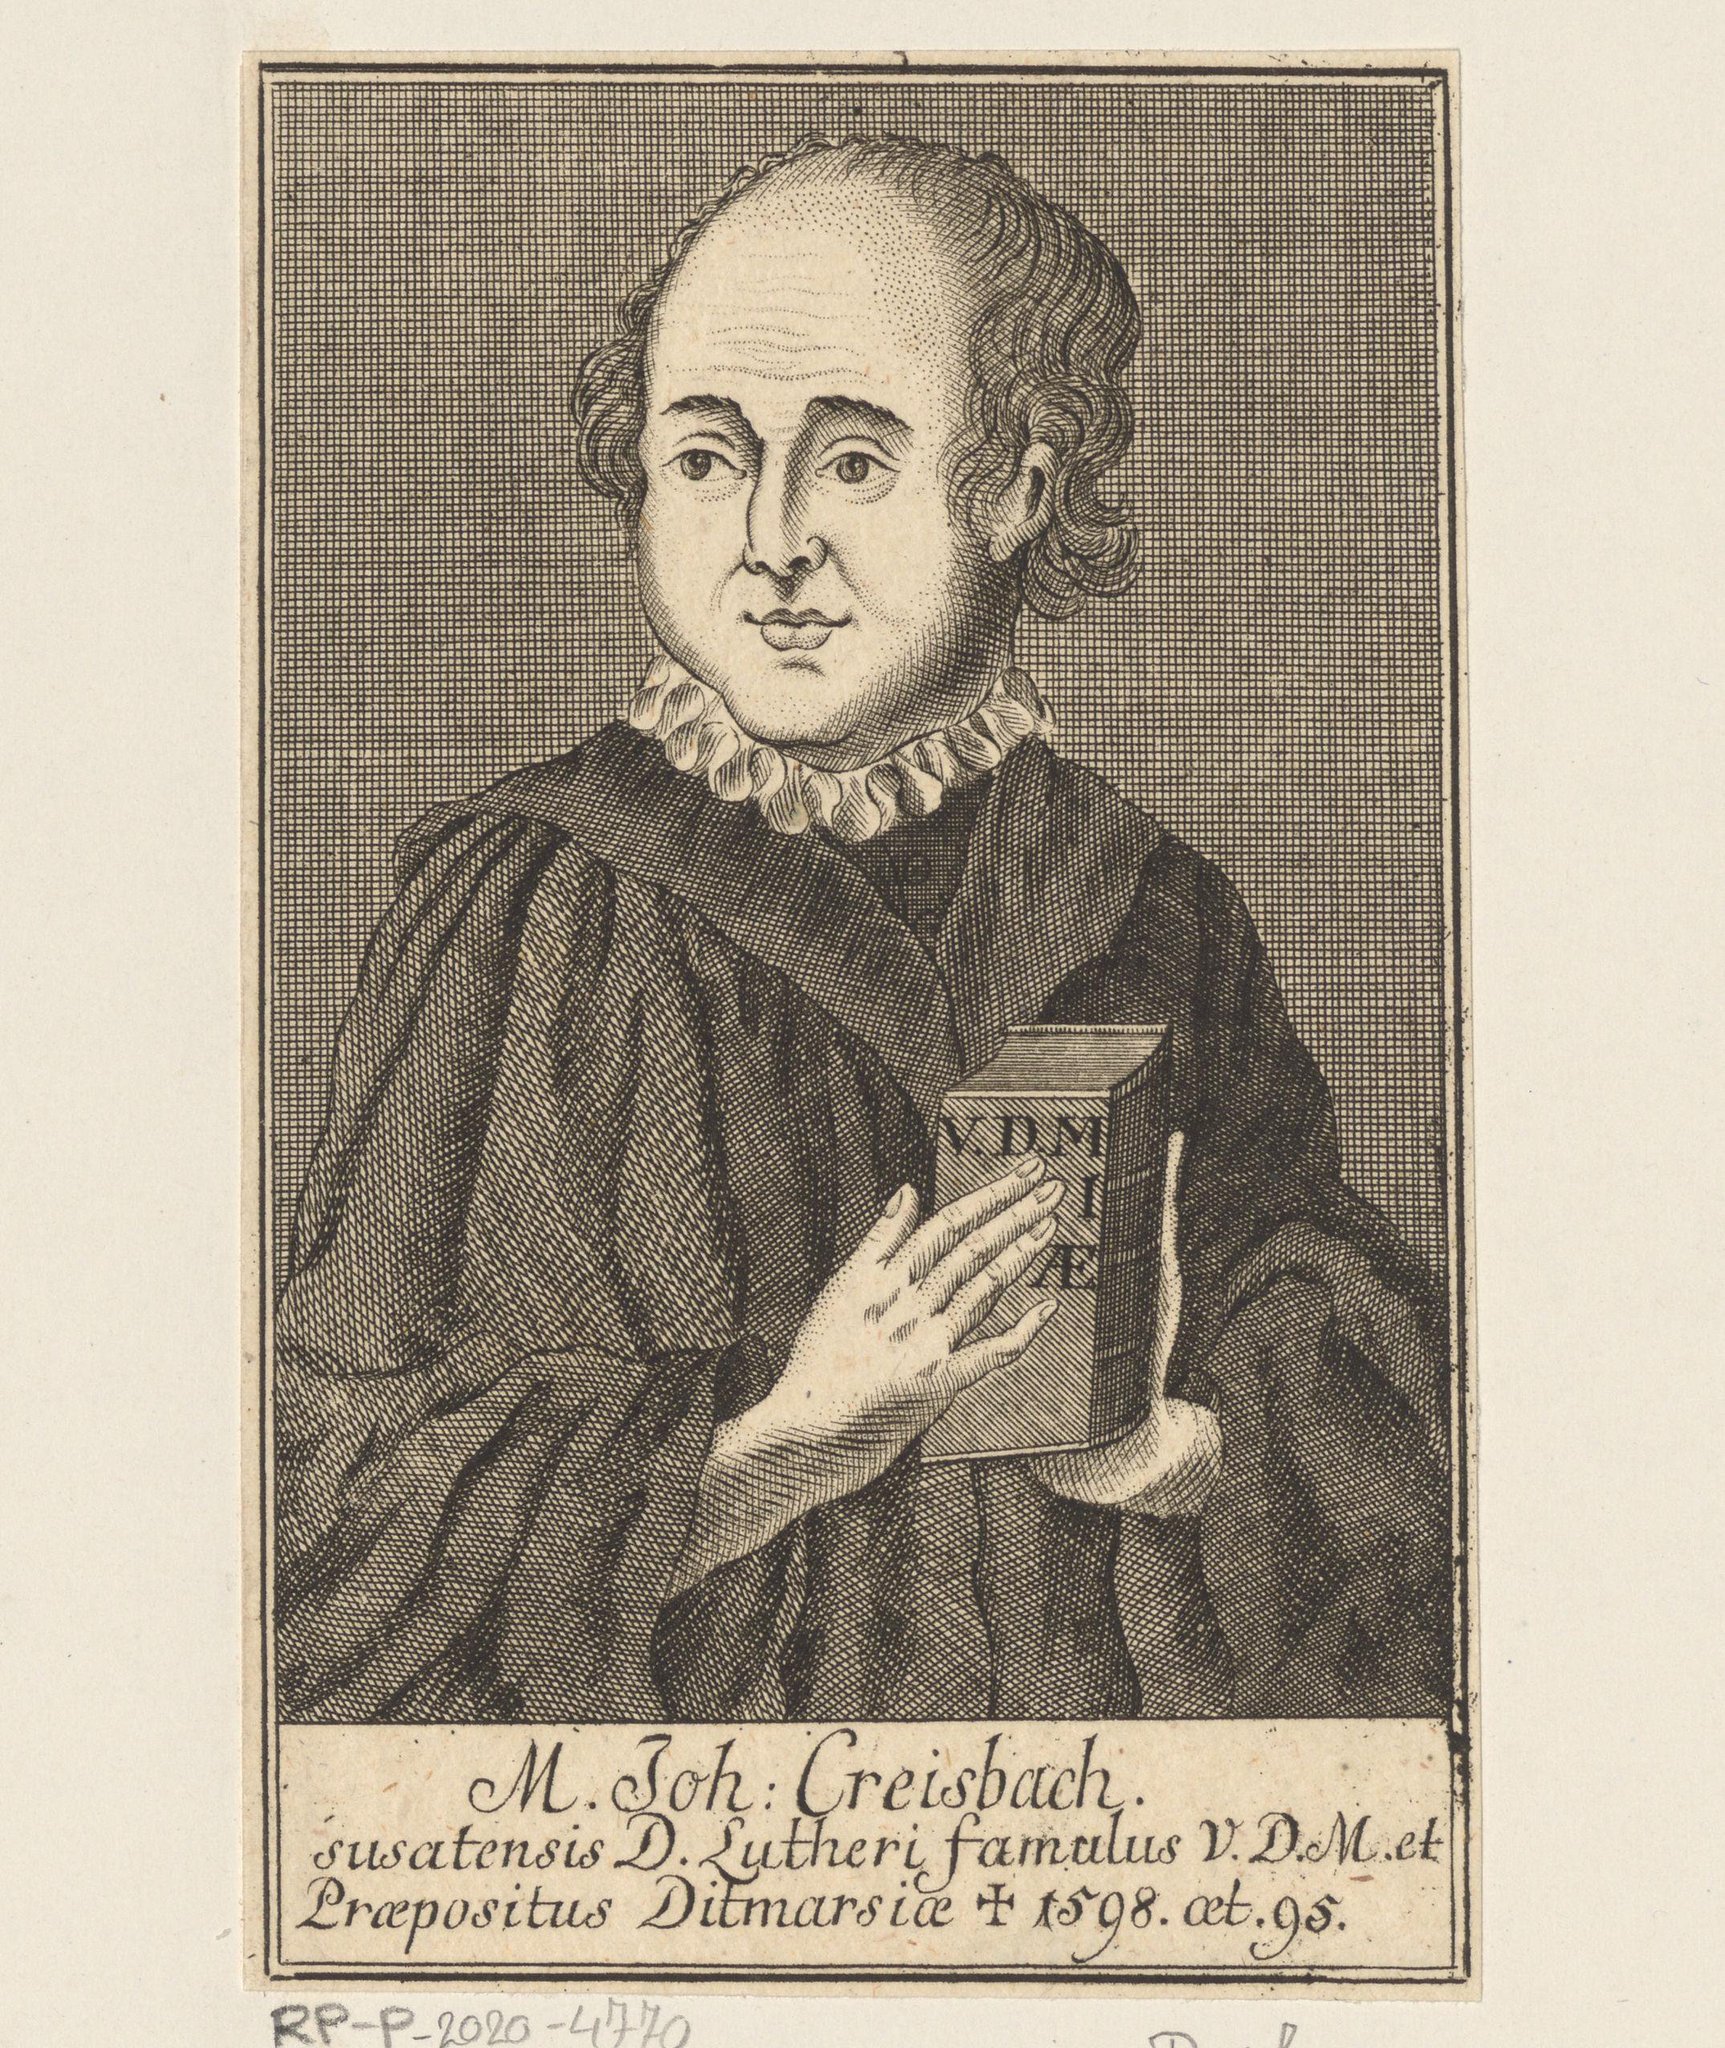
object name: print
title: Portret van Johann Creisbach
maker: Anonymous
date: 1598-1649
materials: paper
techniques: engraving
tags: historical persons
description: Prent maakt deel uit van een grotere prent die later is verknipt. Prent waarschijnlijk uit: Freher, Paul. Theatrum virorum eruditione clarorum. Neurenberg: Johann Hoffmann, 1688.